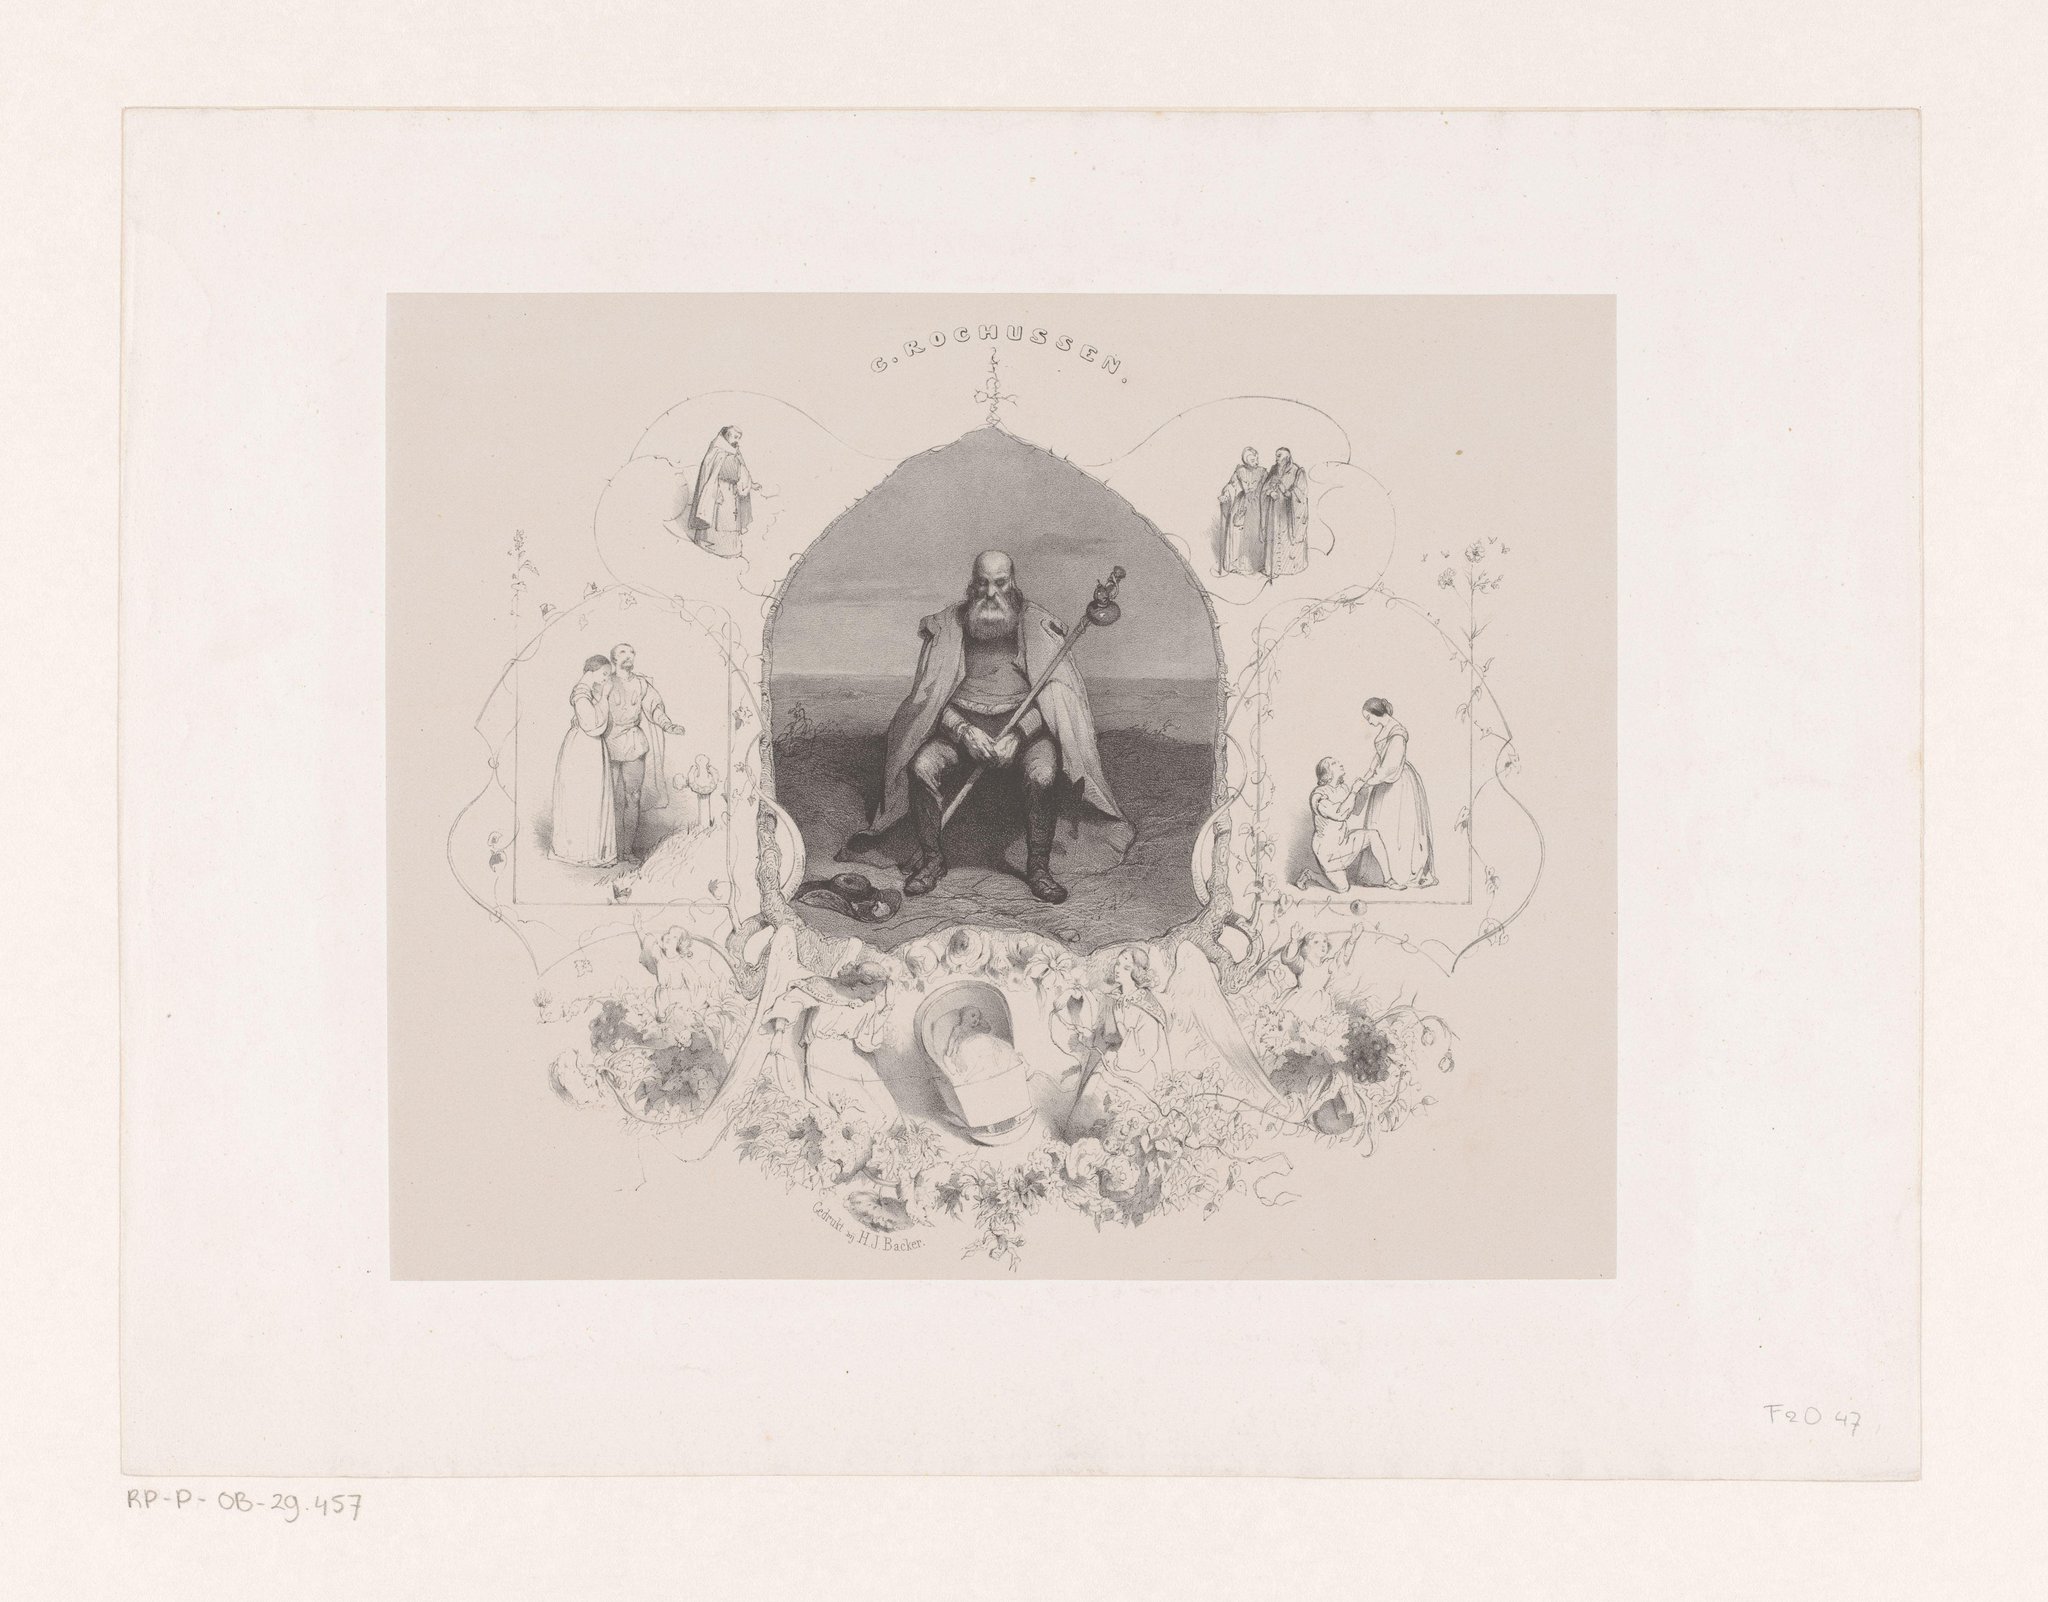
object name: print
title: Zes verschillende levensfasen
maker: hilmar johannes backer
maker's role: print maker, printer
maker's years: 1804-1845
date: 1844-1845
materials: paper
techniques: lithograph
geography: dordrecht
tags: the ages of man, human life divided into stages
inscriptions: collector's mark: Lugt 2228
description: In zes scènes worden de verschillende levensfasen van de mens getoond. In het midden zit een oude man met pelgrimsstok in een landschap. Rondom een baby in een wieg, een verliefd jong koppel, een oud koppel, een oude man en een volwassen koppel bij een graf.